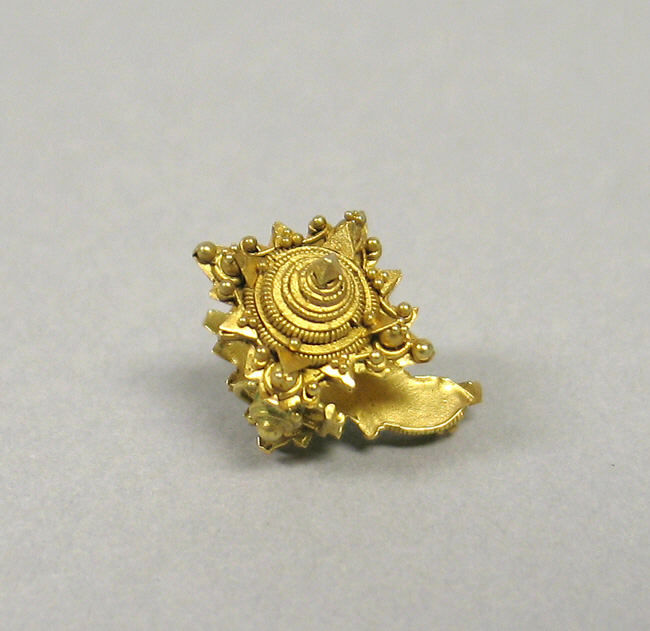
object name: pair of ear ornament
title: Pair of Ear Ornaments, Comma and Star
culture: indonesian, central java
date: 701-1200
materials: gold